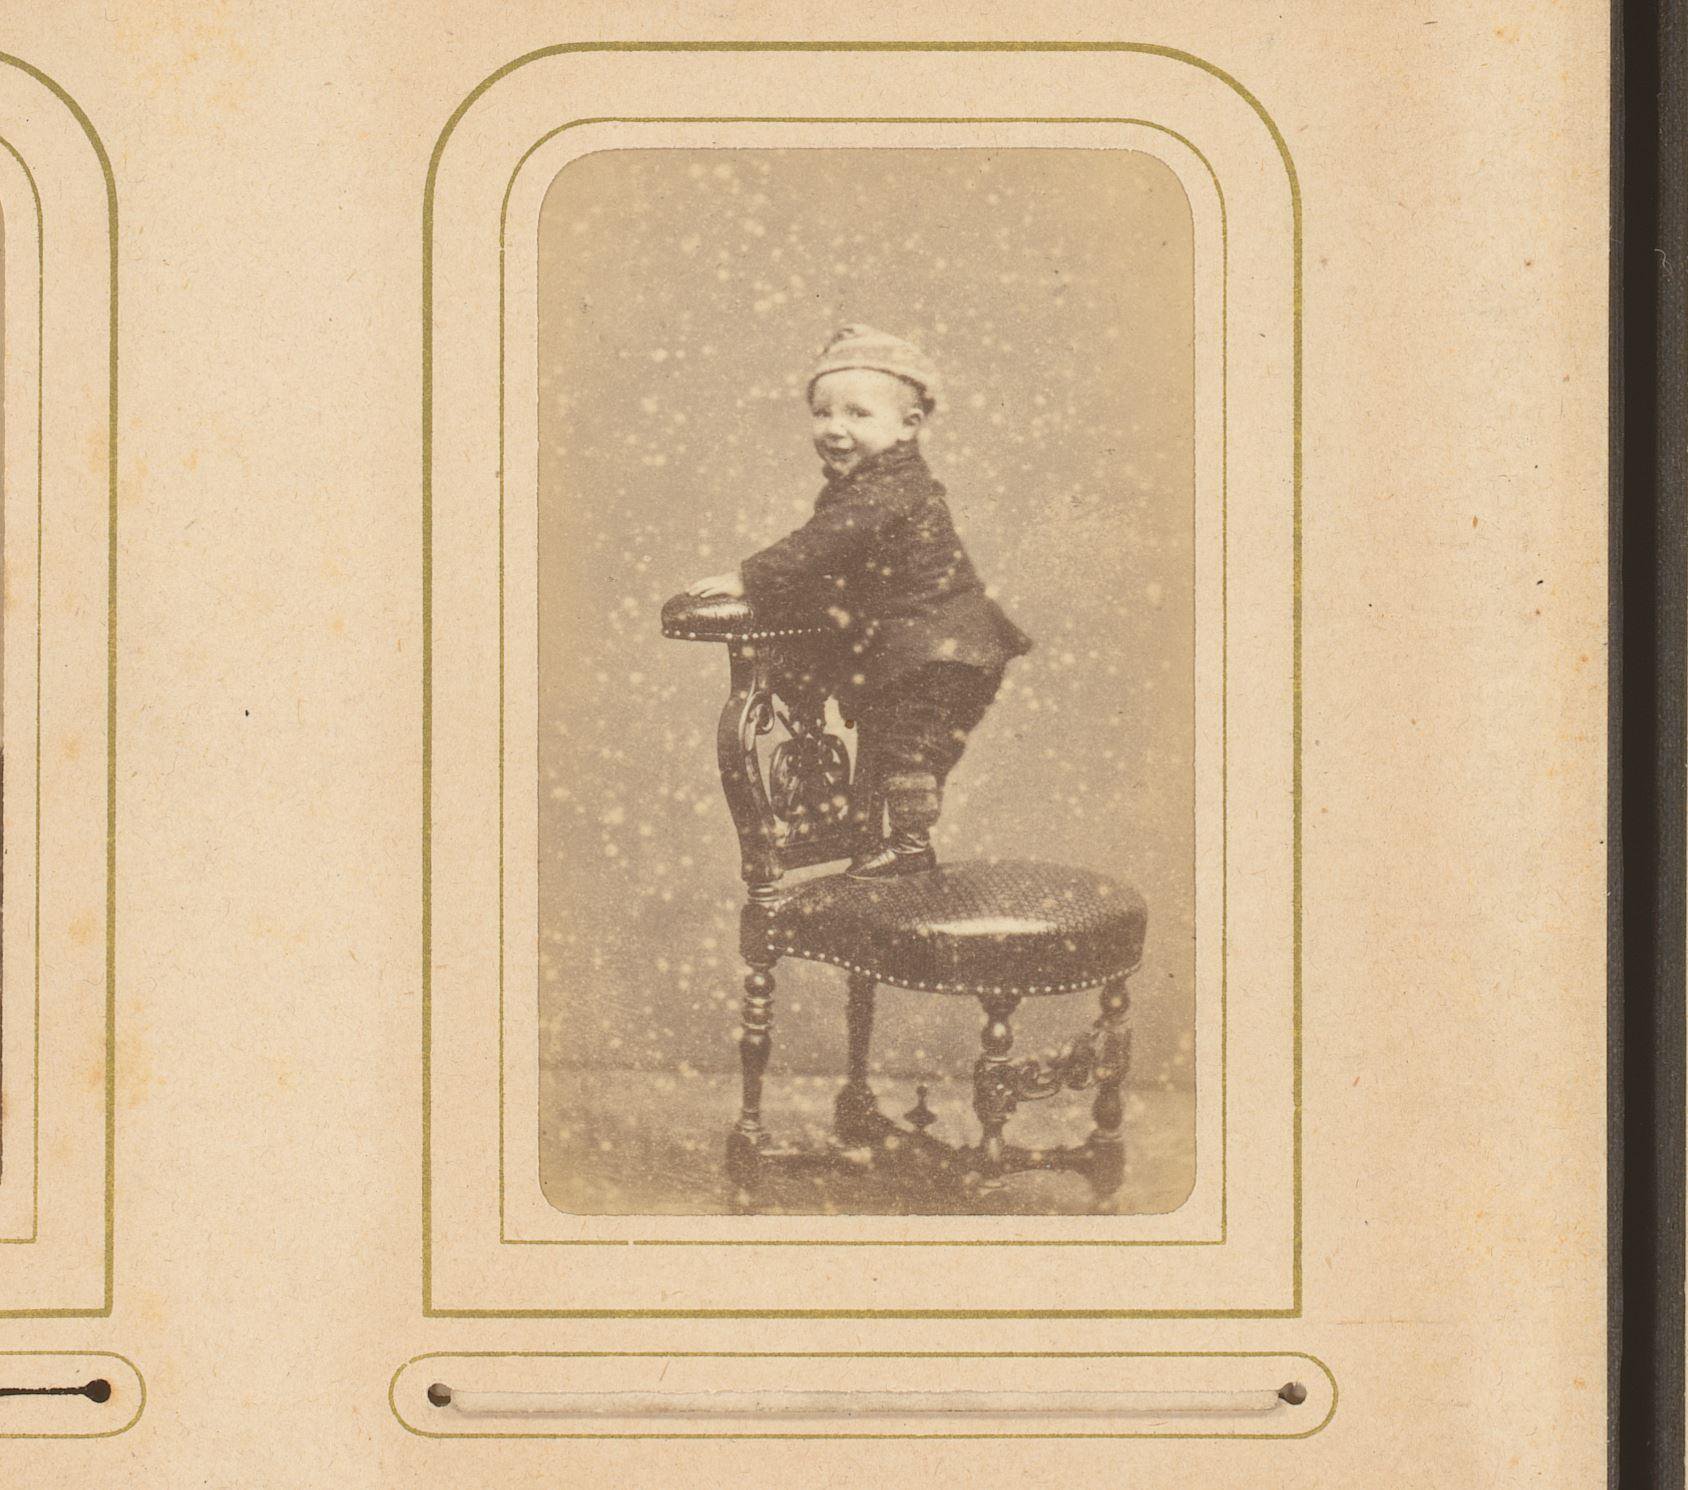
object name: photograph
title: Portret van een jongen, staand op een stoel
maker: charles binger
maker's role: print maker, printer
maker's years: 1830-1916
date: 1862-1869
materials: cardboard, photographic support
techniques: albumen print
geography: haarlem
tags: historical persons, toddler (male), chair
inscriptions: inscription: ‘CH. BINGER & Co./ PHOTOGRAPHISCHE INRIGTING/ ZIJLSTRAAT/ TE/ HAARLEM.’